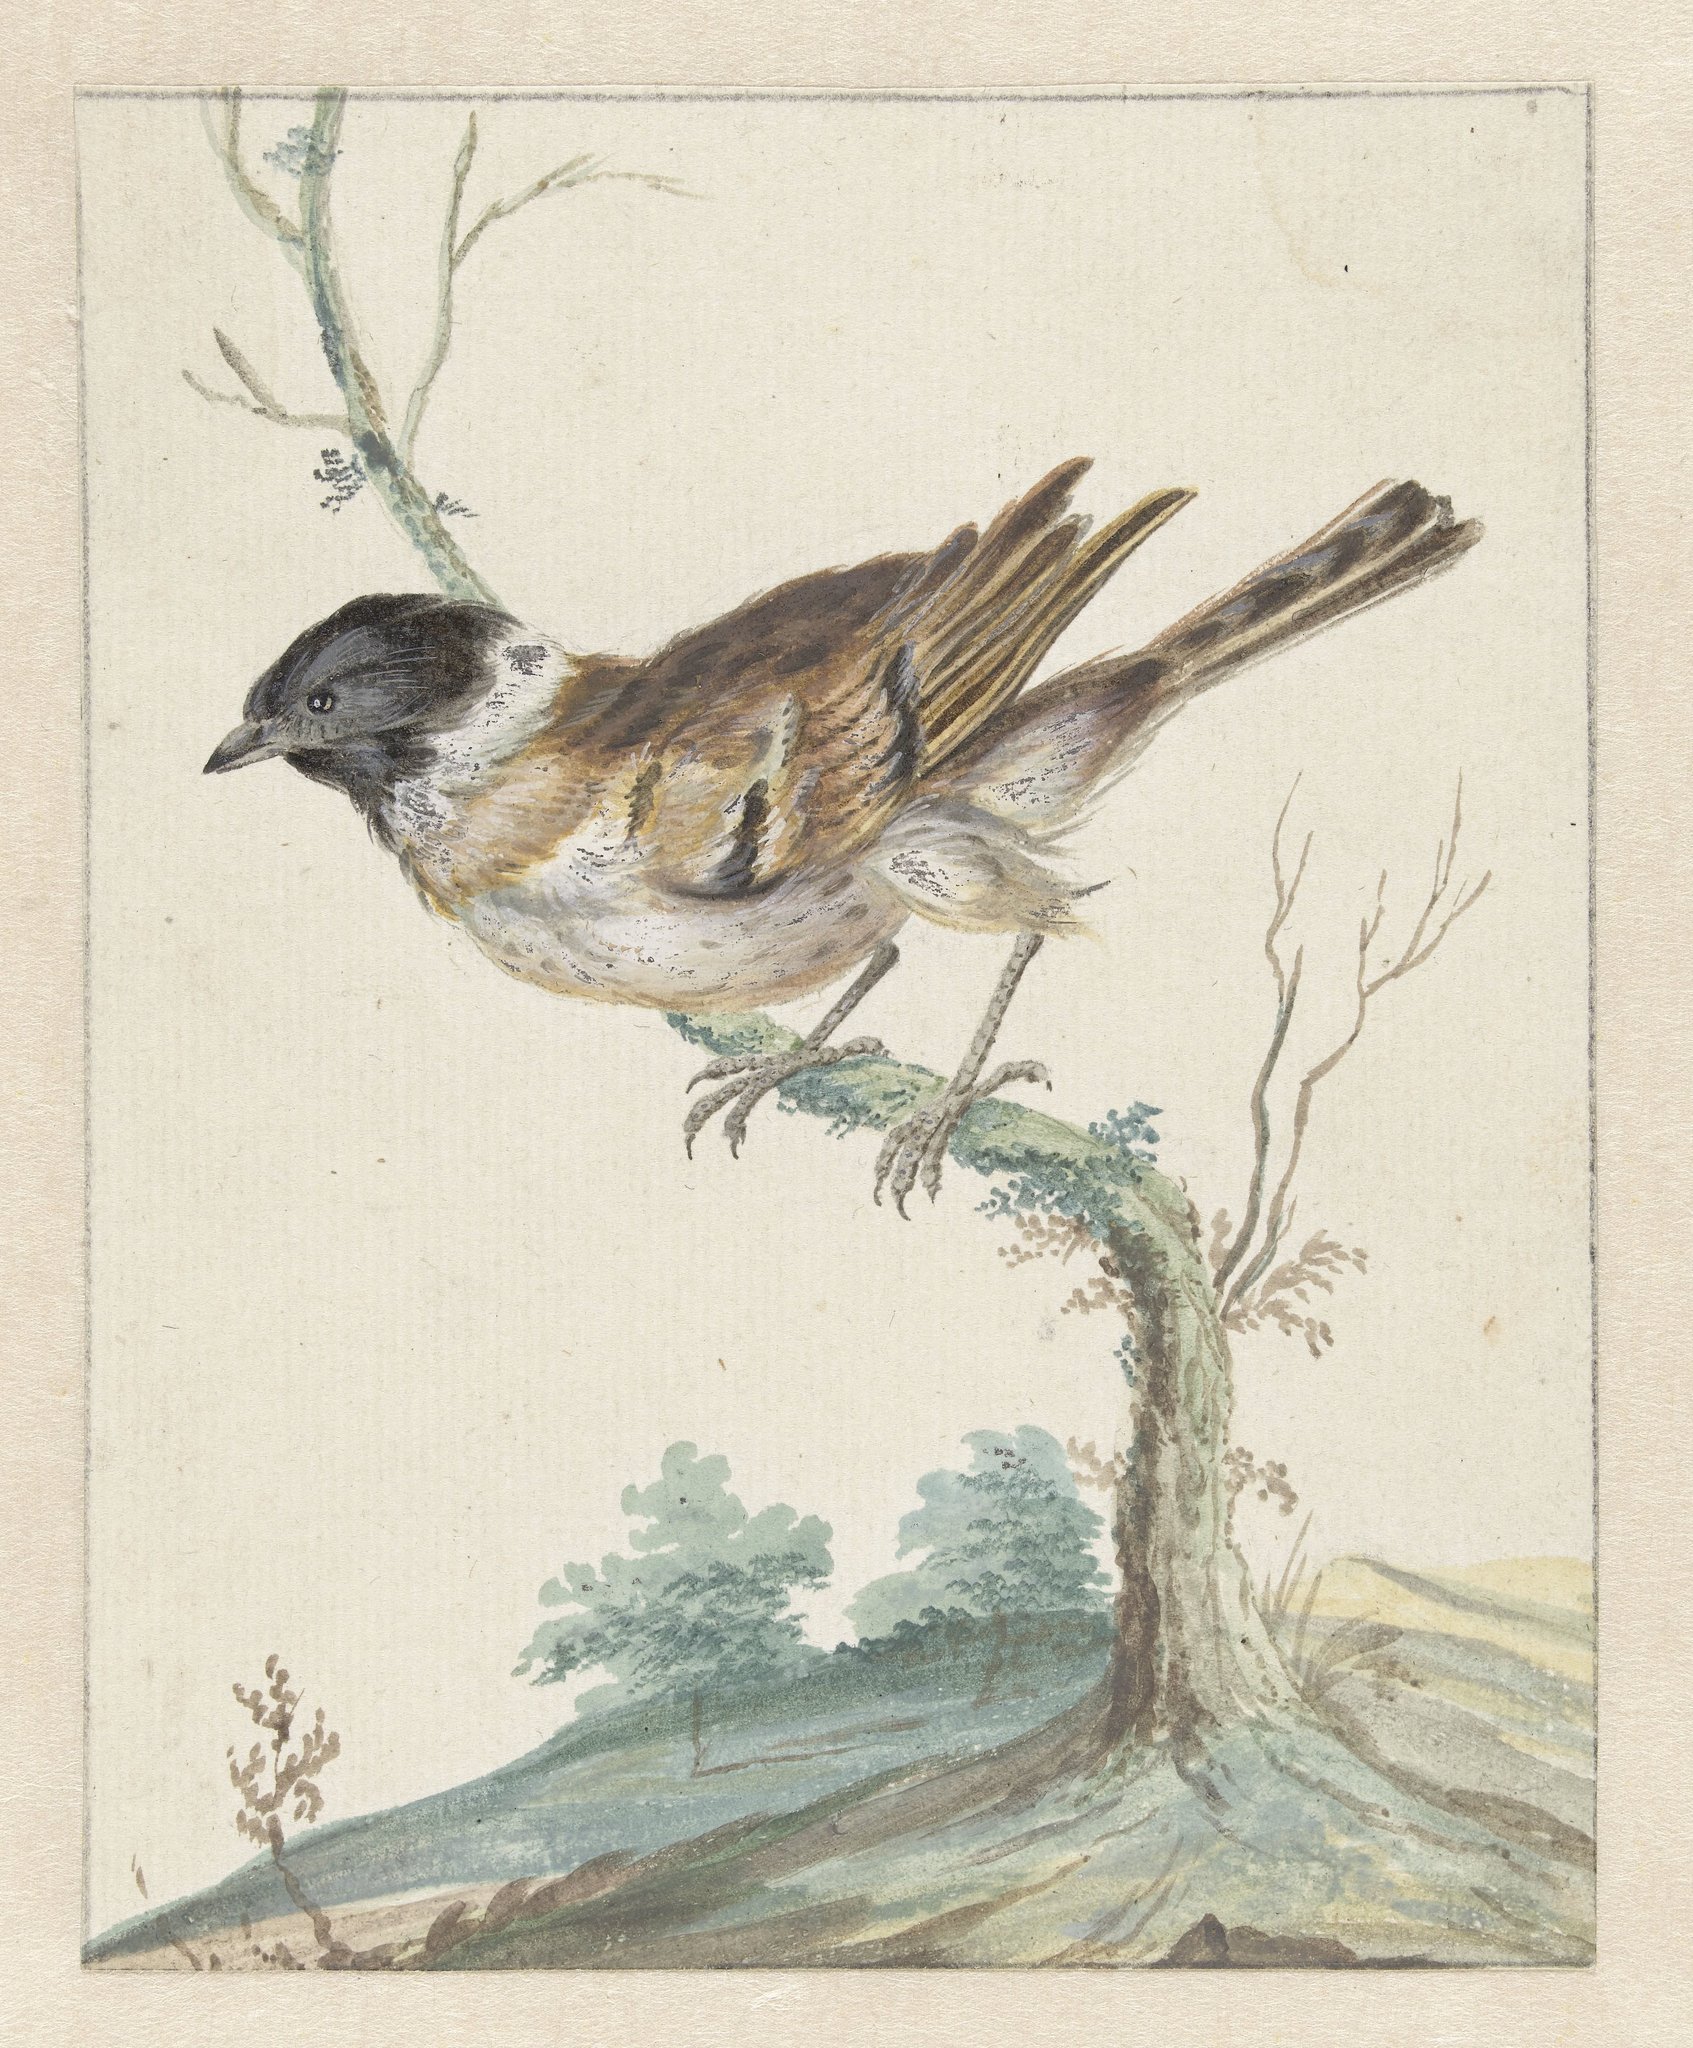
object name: watercolor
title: Rietgors (?)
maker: jan weenix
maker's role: draughtsman, painter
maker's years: 1640-1719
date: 1650-1719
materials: paper, watercolor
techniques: brush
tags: song-birds: reed bunting